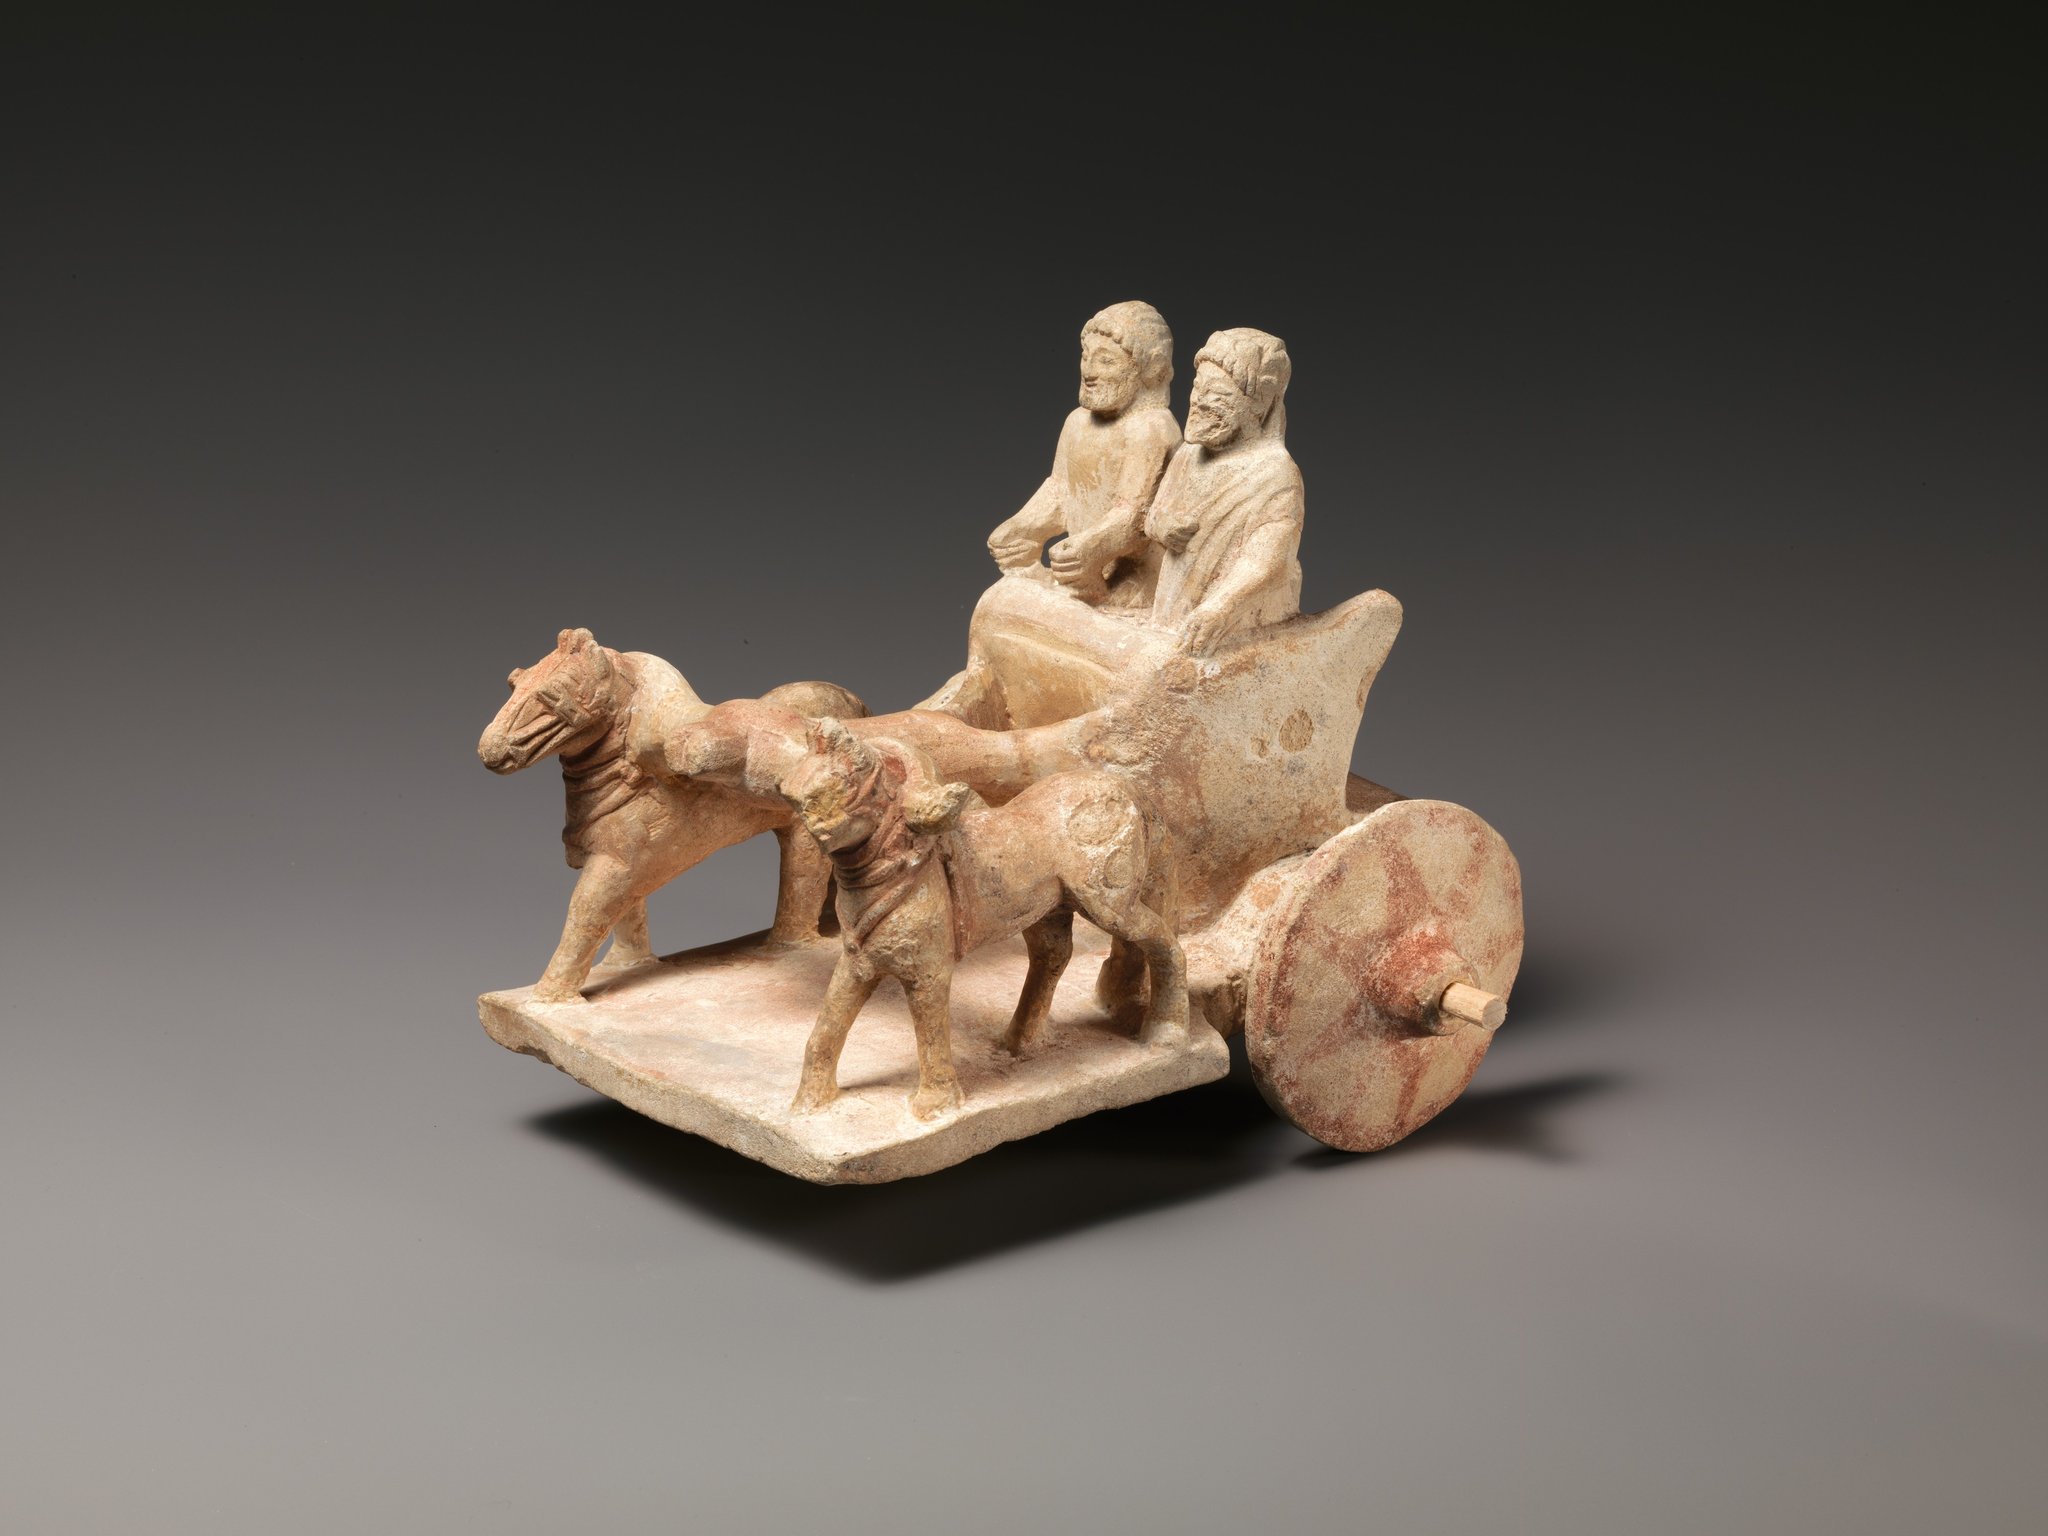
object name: model of a chariot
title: Limestone model of chariot drawn by two horses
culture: cypriot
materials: limestone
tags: men,horses,chariots